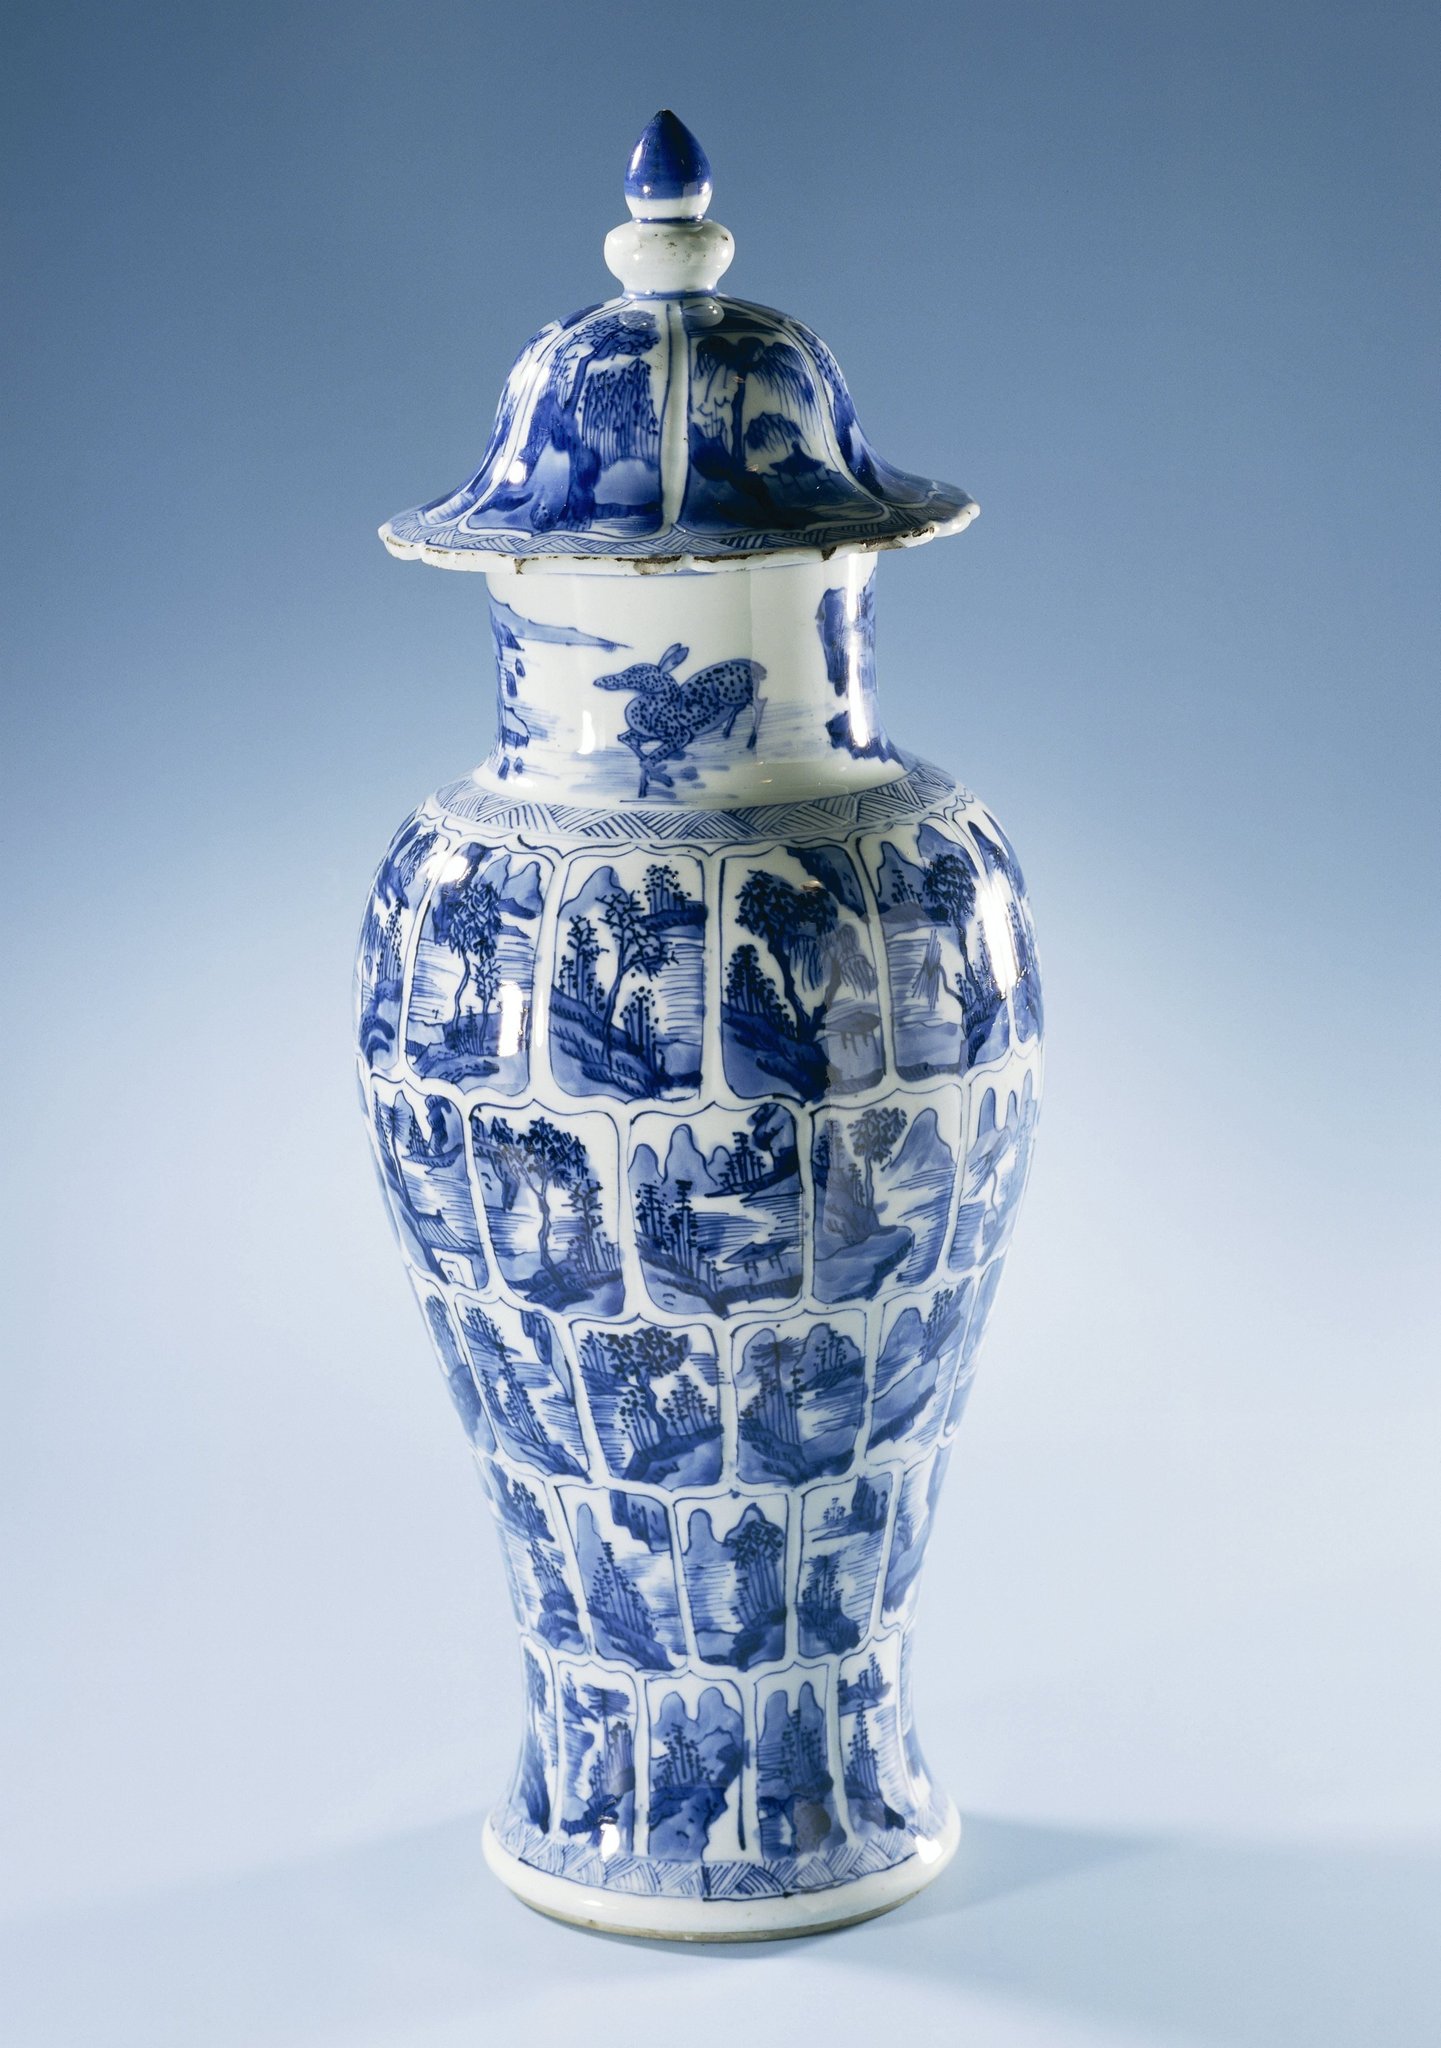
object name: dekselvaas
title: Baluster covered vase with landscapes in panels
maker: Anonymous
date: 1700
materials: cobalt, glaze, paint, porcelain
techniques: firing, turning, vitrification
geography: china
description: Balustervormige dekselvaas van porselein, beschilderd in onderglazuur blauw. De buik is verdeeld in vijf rijen lotusbladvormige cartouches met landschappen. Op de nek een doorlopend landschap. De klokvormige deksel is verdeeld in zes vakken met landschappen. Boven de voet, op de schouder, de rand en de dekselrand een band met een zigzag-patroon. Enkele chips in de rand van de deksel. Dekselvaas is onderdeel van een kaststel. Blauw-wit.